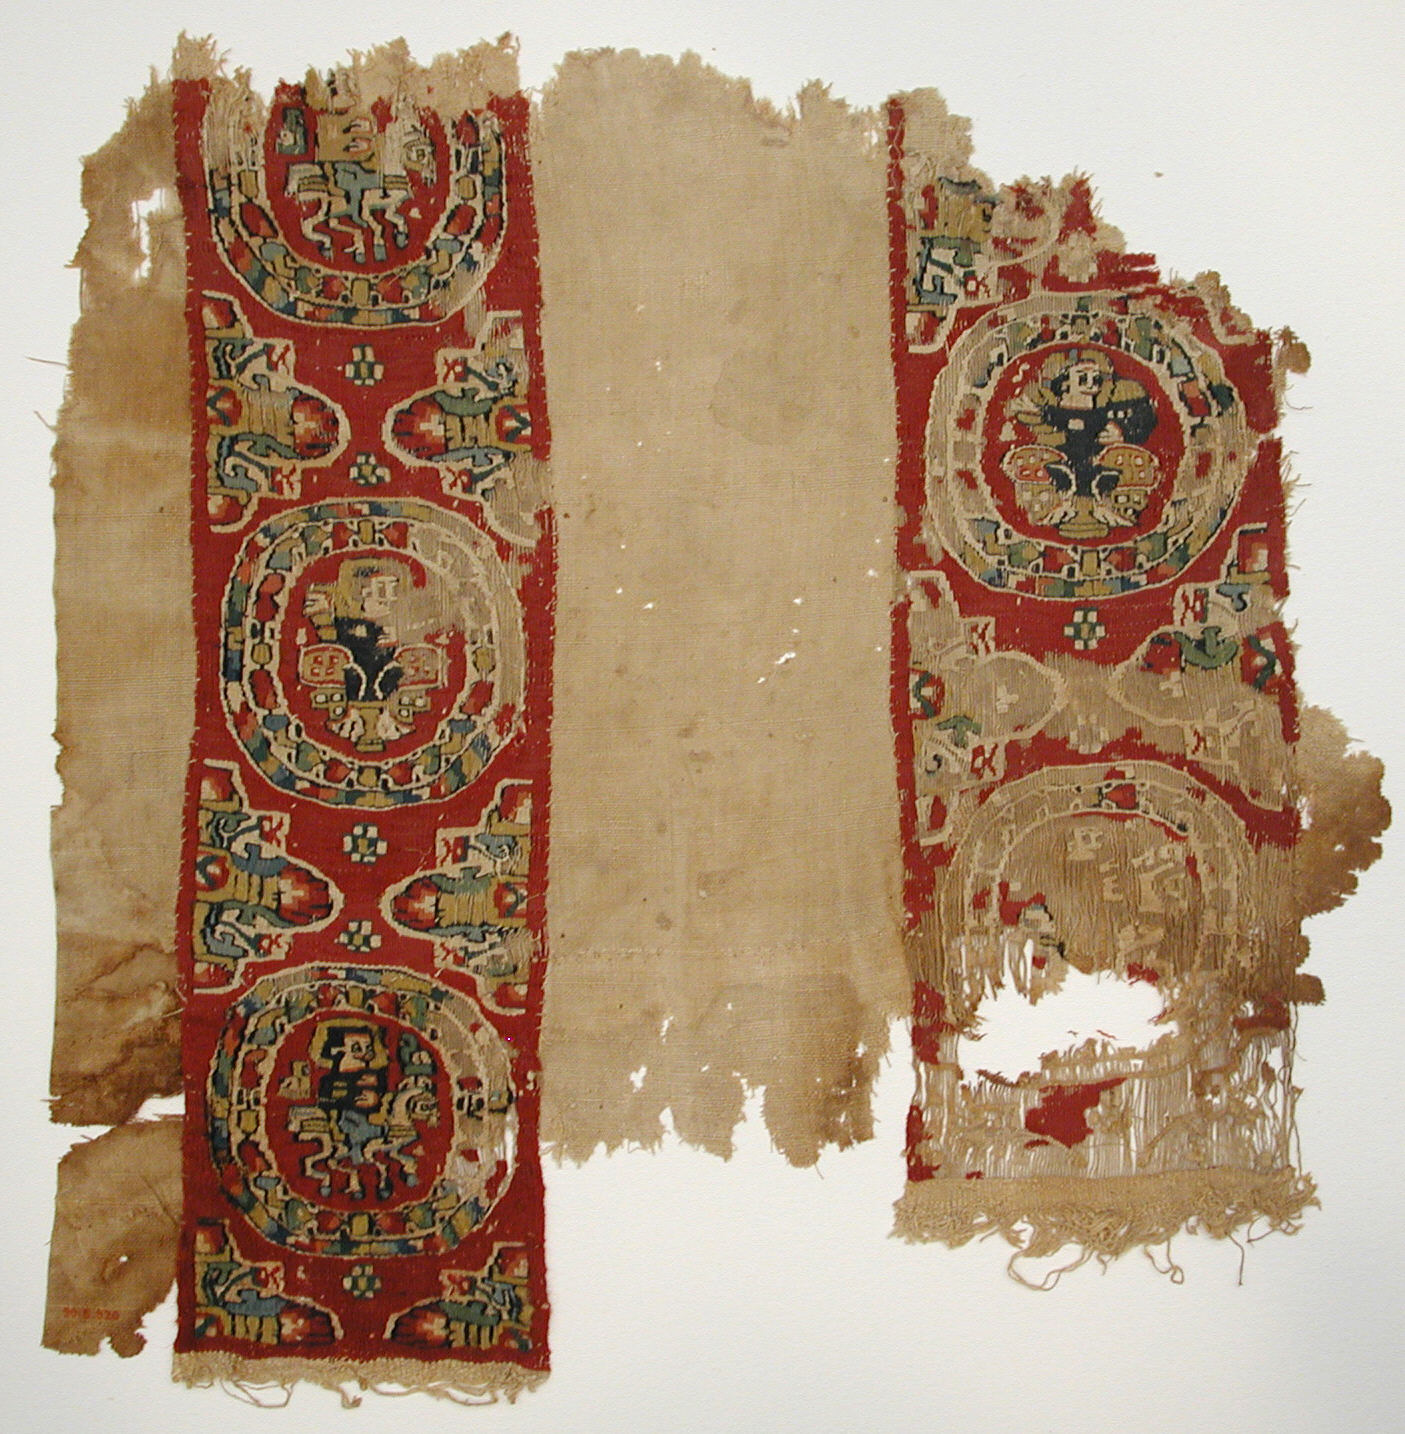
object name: textile fragment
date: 501-700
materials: linen, wool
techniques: weave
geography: egypt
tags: human figures,horses